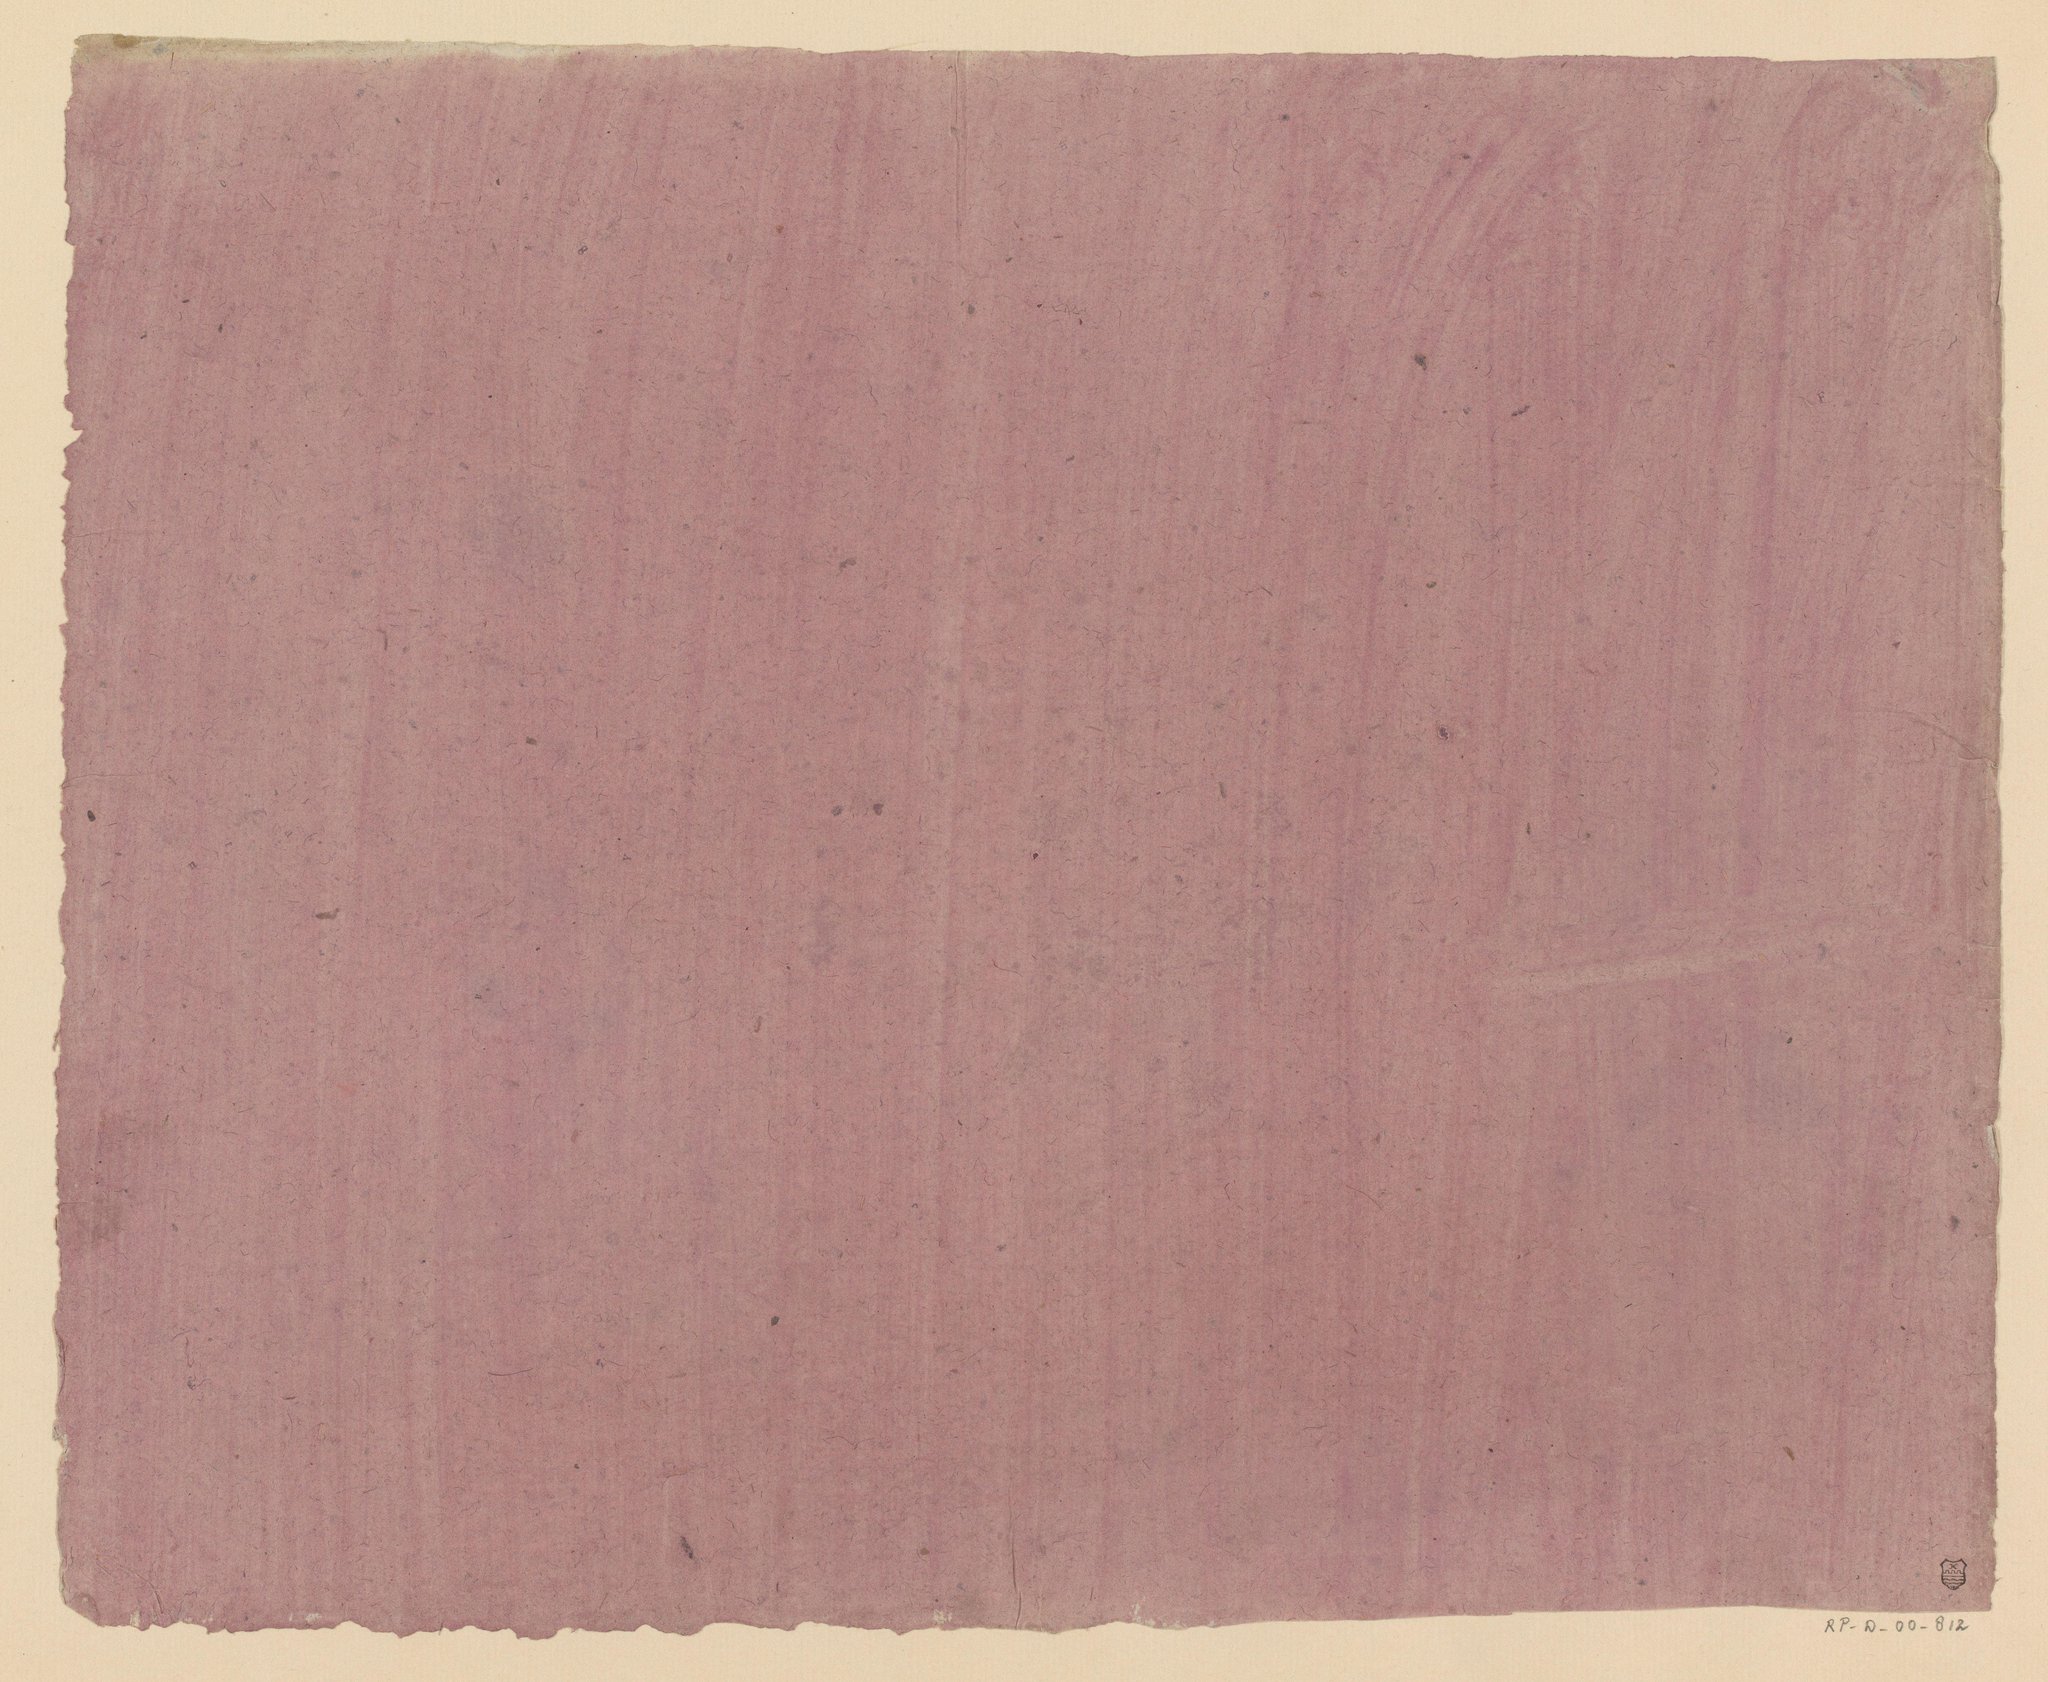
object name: decorated paper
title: Effen roze papier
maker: Anonymous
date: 1800-1900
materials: paint, paper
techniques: hand coloring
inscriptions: collector's mark: Lugt 2760